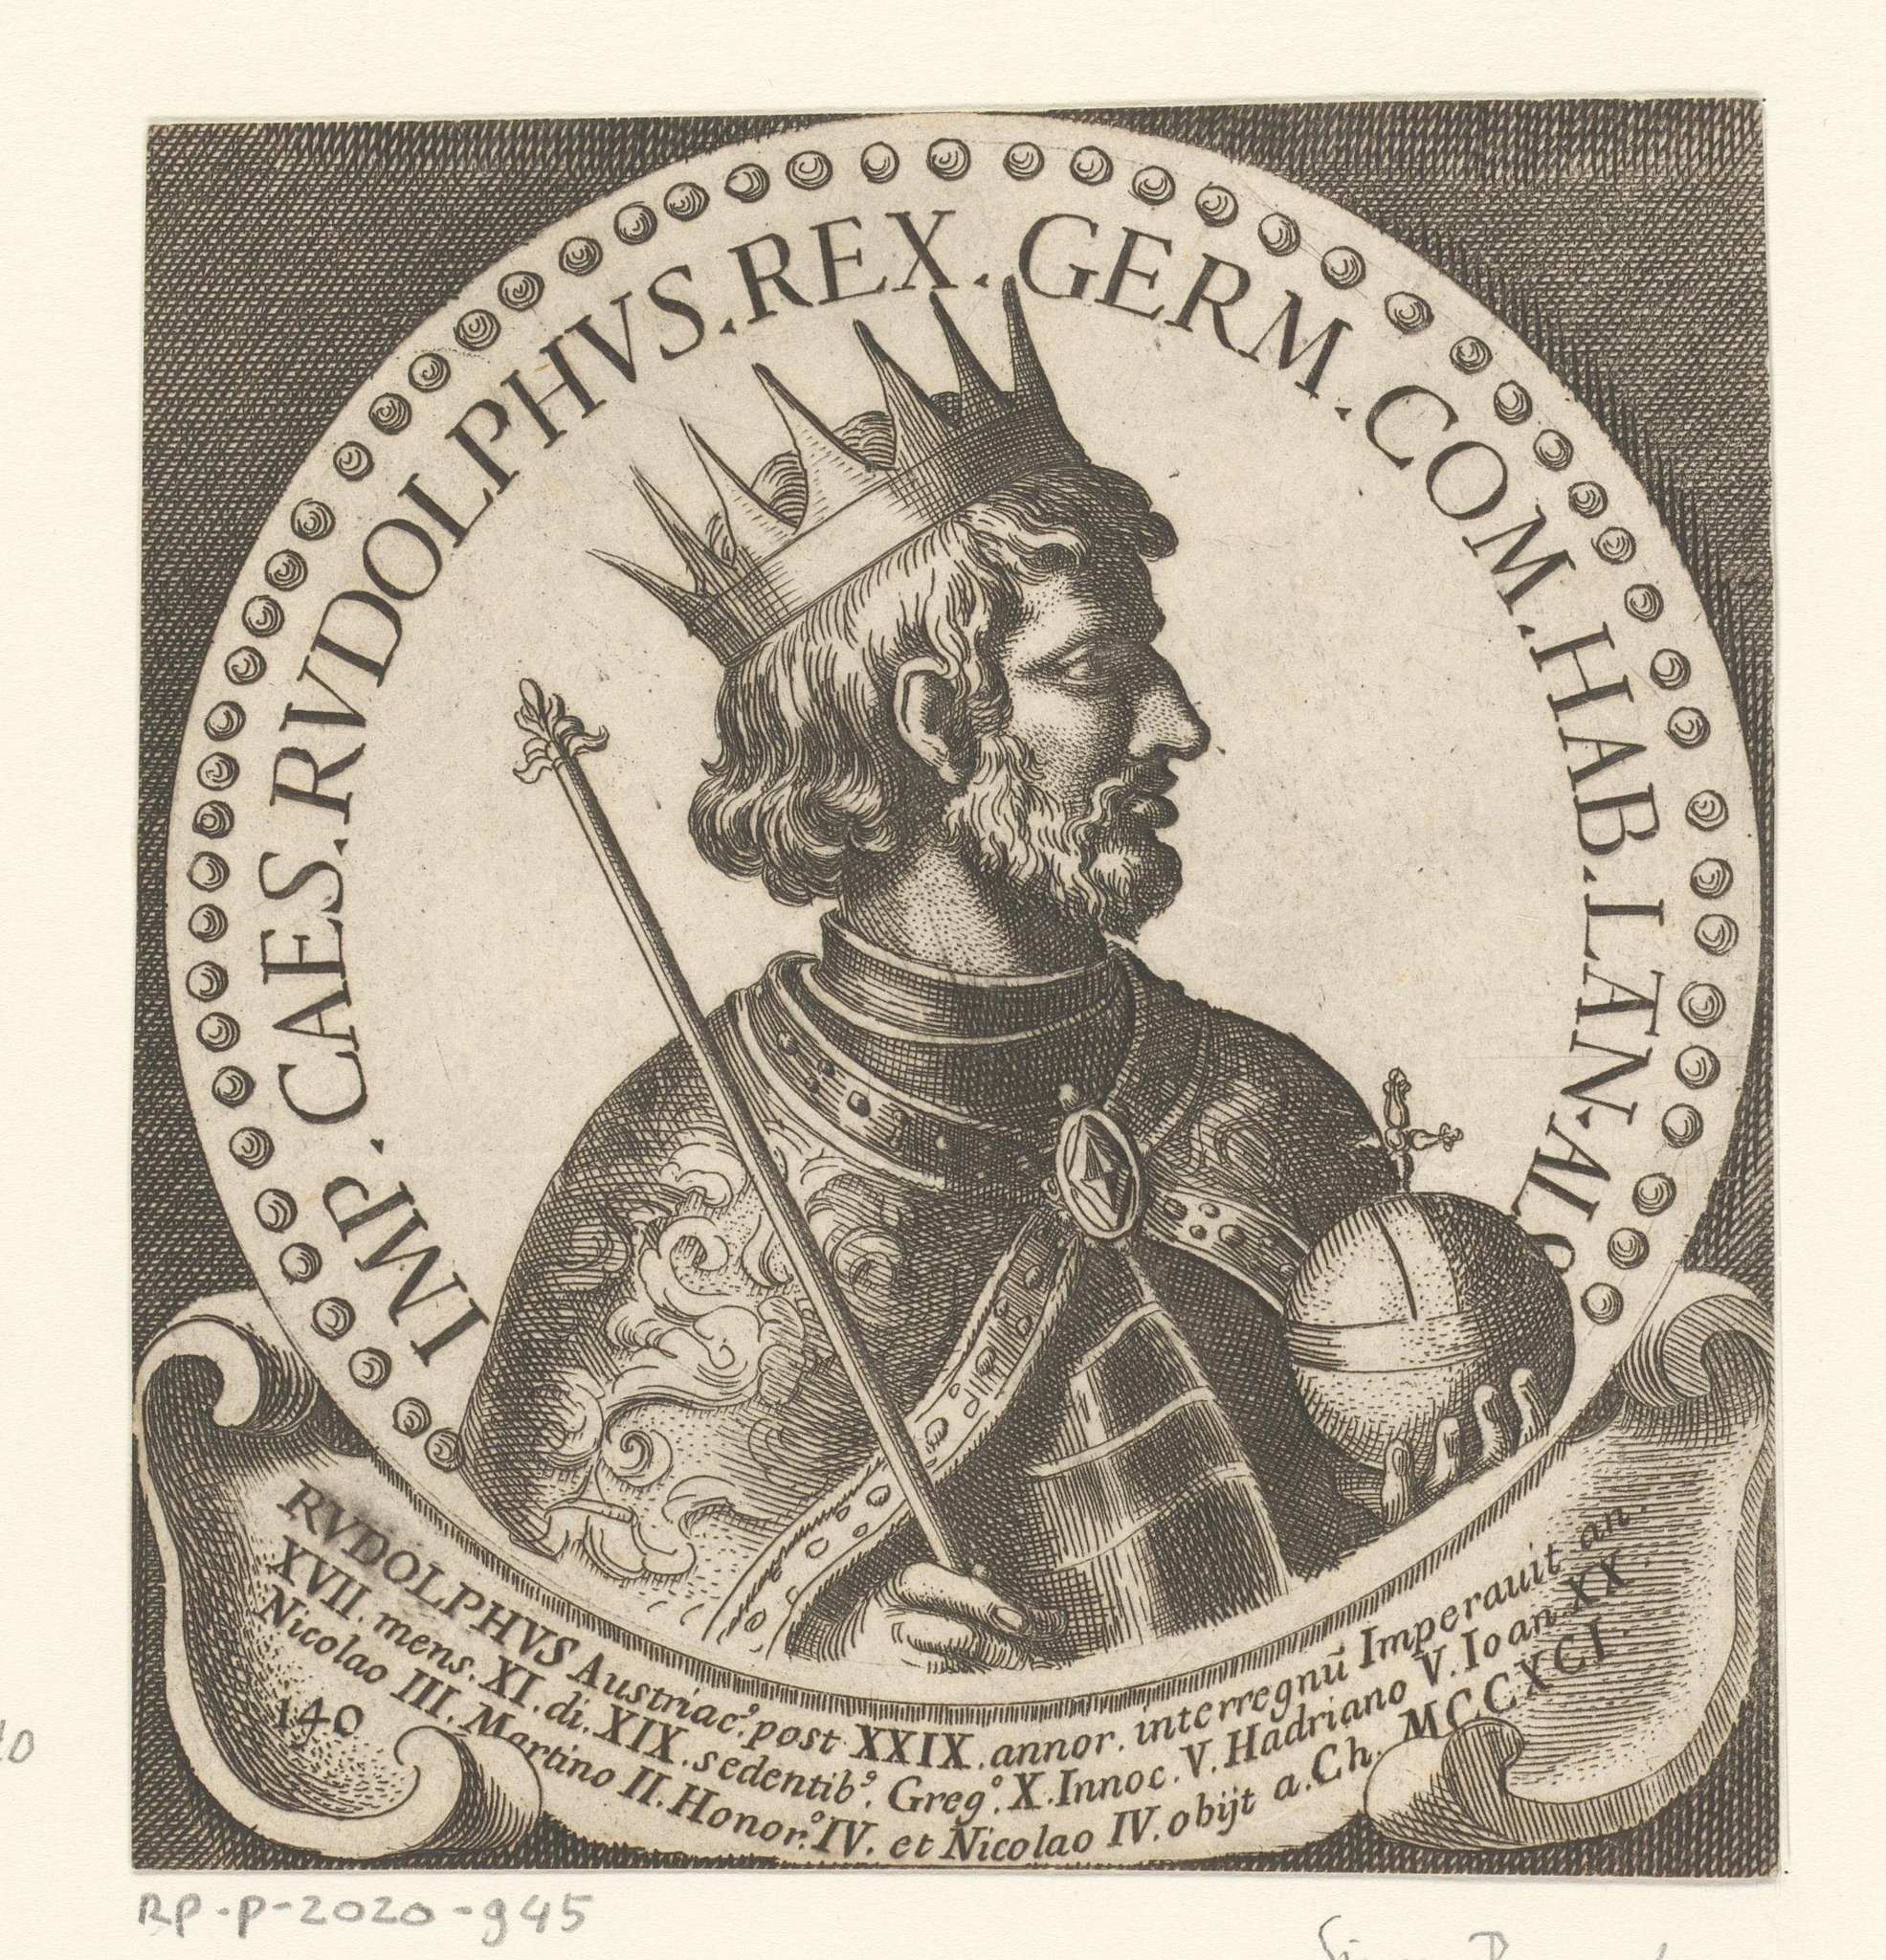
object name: print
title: Portret van Rudolf I van Habsburg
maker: Anonymous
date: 1700-1799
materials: paper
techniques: engraving, etching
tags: crown (symbol of sovereignty), sceptre, staff (symbol of sovereignty), historical persons, king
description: In een cirkel met daaronder een cartouche met een Latijnse tekst. Linksonder genummerd: 140.